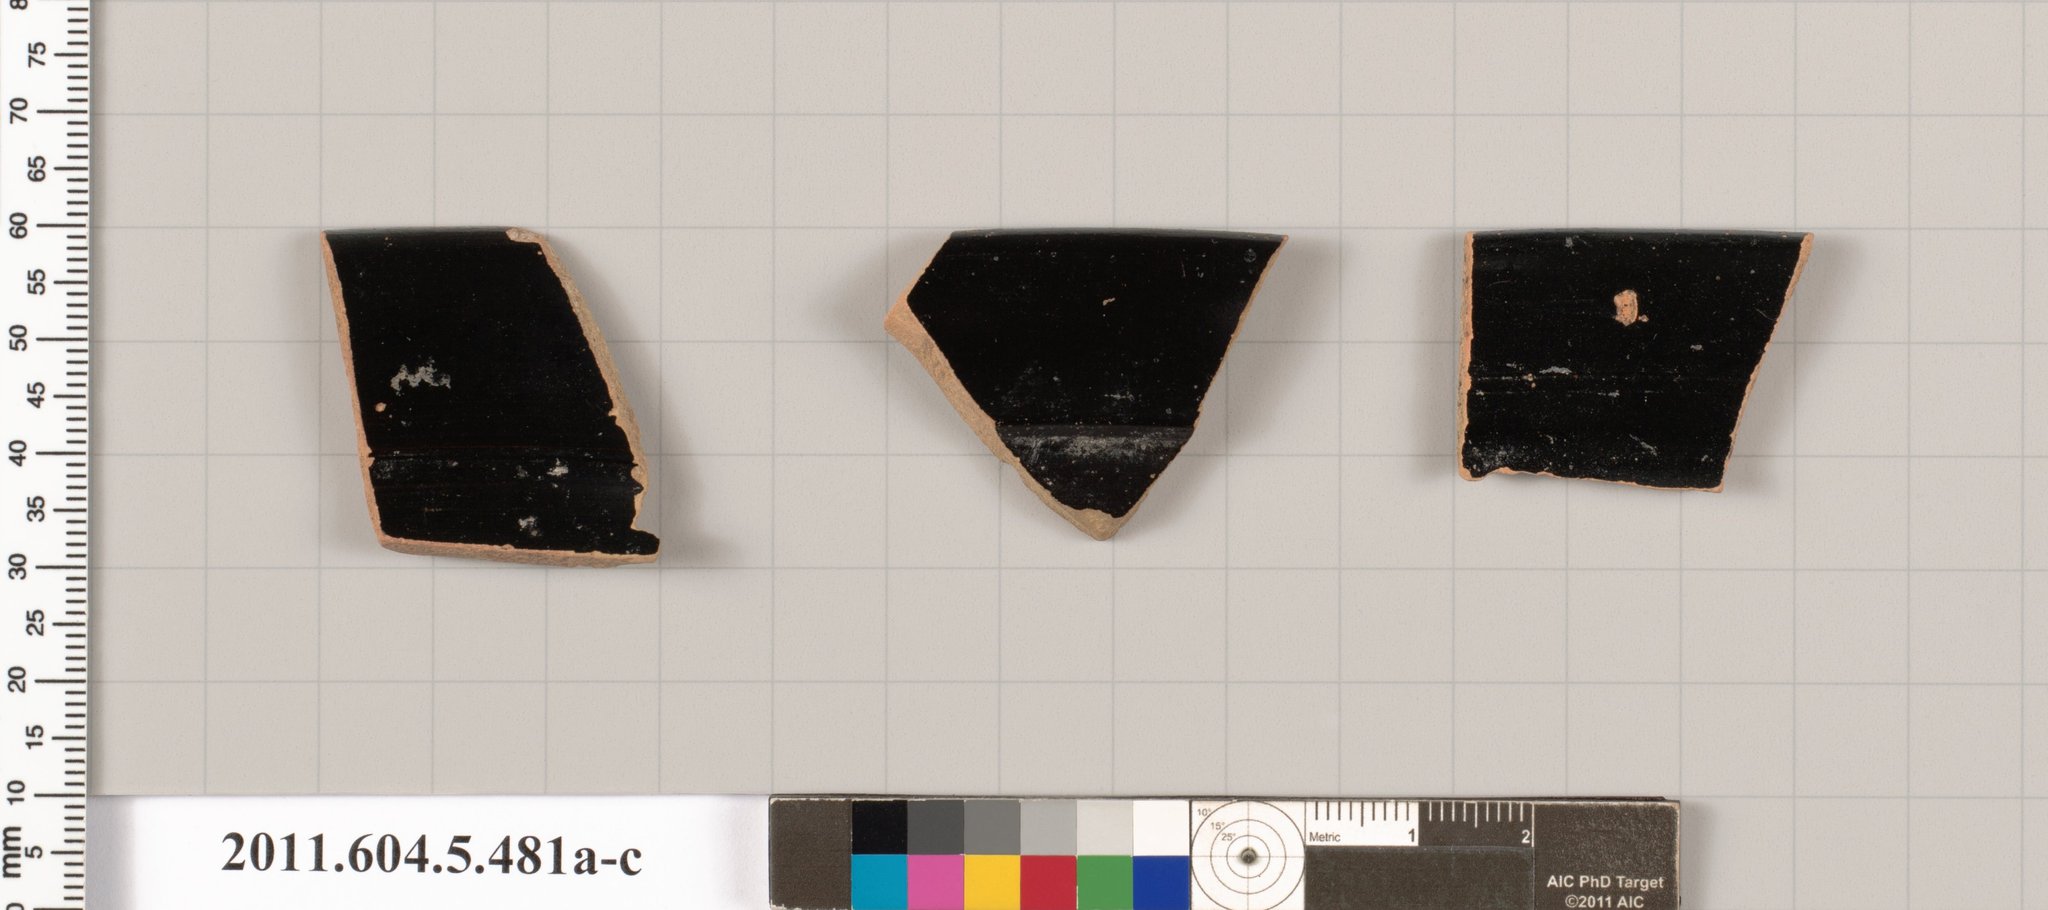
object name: kylix fragment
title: Terracotta rim fragments of kylikes (drinking cups)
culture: greek, attic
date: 600-401 BCE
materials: terracotta